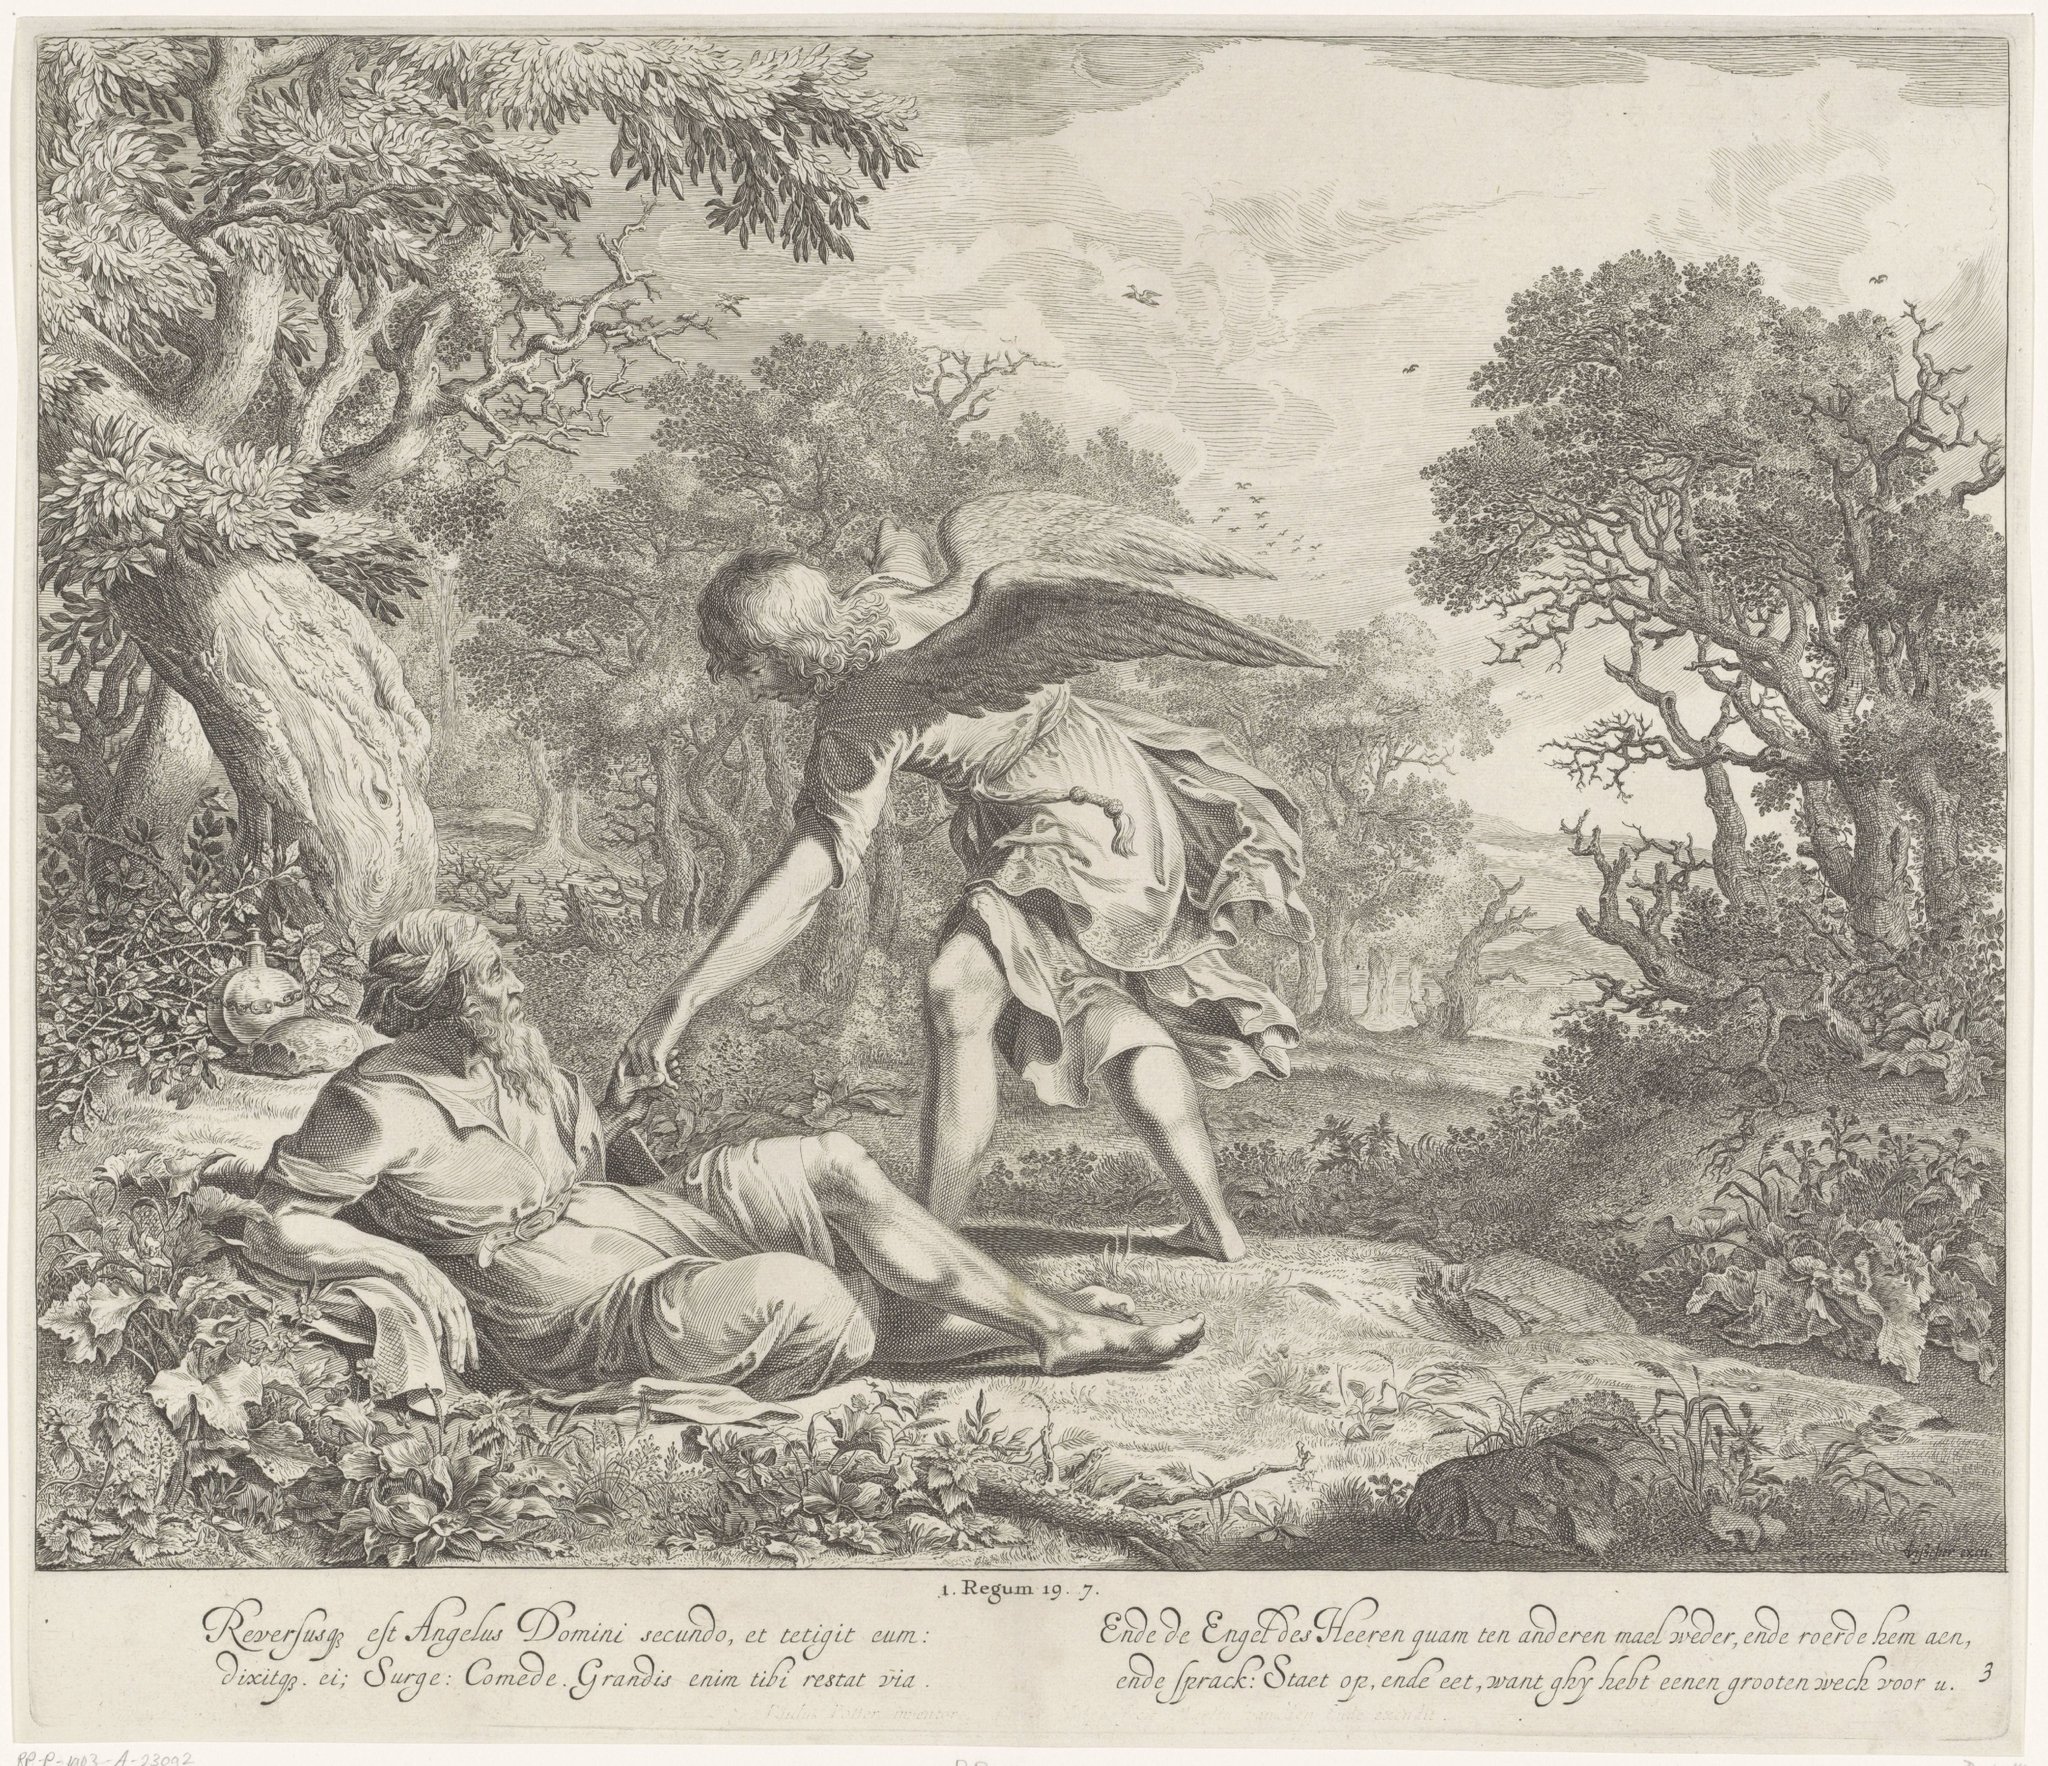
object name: print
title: Elia en de engel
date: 1623-1652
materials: paper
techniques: engraving, etching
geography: antwerp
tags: an angel wakes elijah; a loaf of bread and a jar of water are usually at elijah's head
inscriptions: collector's mark: Lugt 2228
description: De Amsterdamse uitgever Claes Jansz. Visscher (II) produceerde vanaf de jaren ’30 van de zeventiende eeuw grote Bijbelse prenten op zogenaamd royaal-formaat papier (ca. 480 x 580 mm). Na zijn dood in 1652 zette zijn zoon Nicolaes Visscher (I) het bedrijf voort en zo ook de uitgave van Royaalbijbelprenten. Toen Nicolaes in 1679 overleed nam zijn zoon Nicolaes Visscher (II) het bedrijf over en gaf kort hierna, omstreeks 1680, een fondslijst uit. Hierin worden 130 prenten met Bijbelse voorstellingen op royaalpapier beschreven (zie documentatie J. van der Waals). Complete prentbijbels op royaal-formaat werden door vader en zoon Nicolaes Visscher uitgegeven onder de titel Historiae Sacrae Veteris et Novi Testamenti. De bladen werden echter ook los verkocht en konden worden gecombineerd met Royaalbijbel-prenten van andere uitgevers. Verschillende Amsterdamse uitgevers brachten namelijk ook bijbelprenten op royaal-formaat uit, onder wie Clement de Jonghe en Cornelis Danckerts. De door de firma Visscher uitgegeven prenten zijn veelal vervaardigd door anonieme prentmakers naar voorbeeld van verschillende zestiende- en zeventiende-eeuwse Bijbelse prenten en prentreeksen. Veelal moesten de composities worden aangepast aan het grotere en langgerekte royaal-formaat. Daarnaast zijn er ook grote bladen van bekende prentmakers zoals Jan van Londerseel, Pieter Nolpe, Jacques de Gheyn (II) en Jan Harmensz. Muller opgenomen in de categorie ‘Bybelsche Figuren, op Royaal-bladen’ in de fondslijst van Visscher. Prent mogelijk gebruikt in: Historiae Sacrae Veteris et Novi Testamenti (Royaalbijbel). Amsterdam: Nicolaes Visscher (I) en (II), [1652-1702]. In de fondslijst van Nicolaes Visscher II (ca. 1680) is het onderwerp van deze prent onder de titel 'Bybelsche Figuren, op Royaal-bladen. bestaande uyt de volgende historien.' als volgt genummerd: 50.